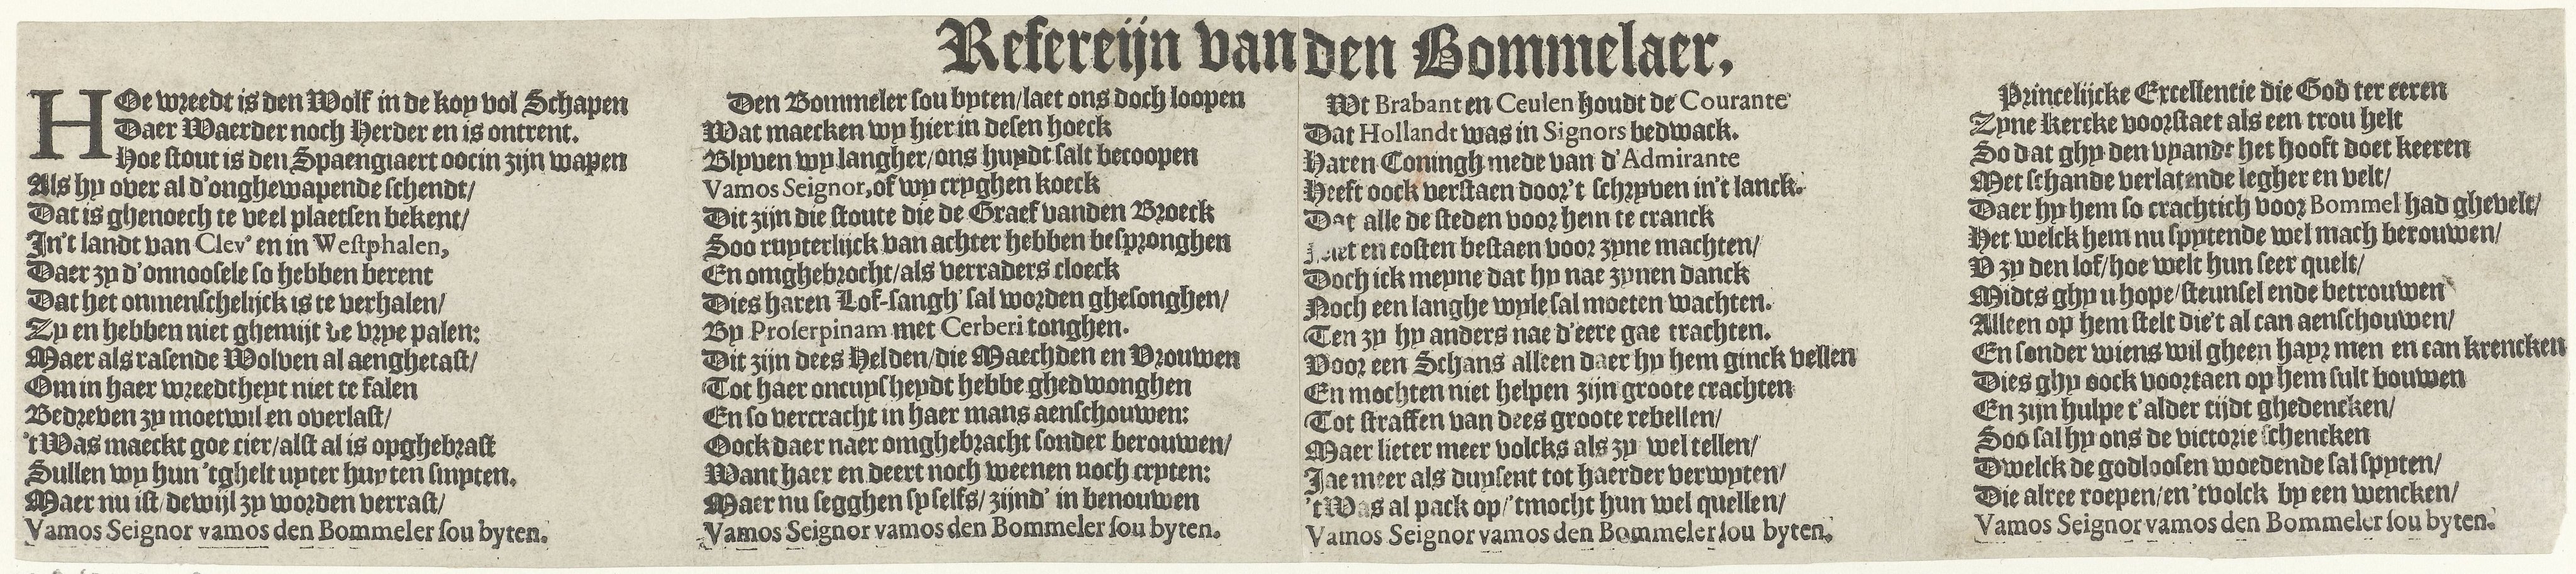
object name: text sheet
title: Refereijn van den Bommelaer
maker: Anonymous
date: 1599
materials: paper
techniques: letterpress printing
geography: low countries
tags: the hague, maurice (prince of orange)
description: Dit tekstblad behoort bij de prent beschreven door Muller onder nummer FMH 1097 en niet bij de prent met de Strijd bij Heerewaarden, FMH 1098[a]. Zie over deze verwisseling: C. Klinkert in 'Nassau in het Nieuws', pp. 204-208.